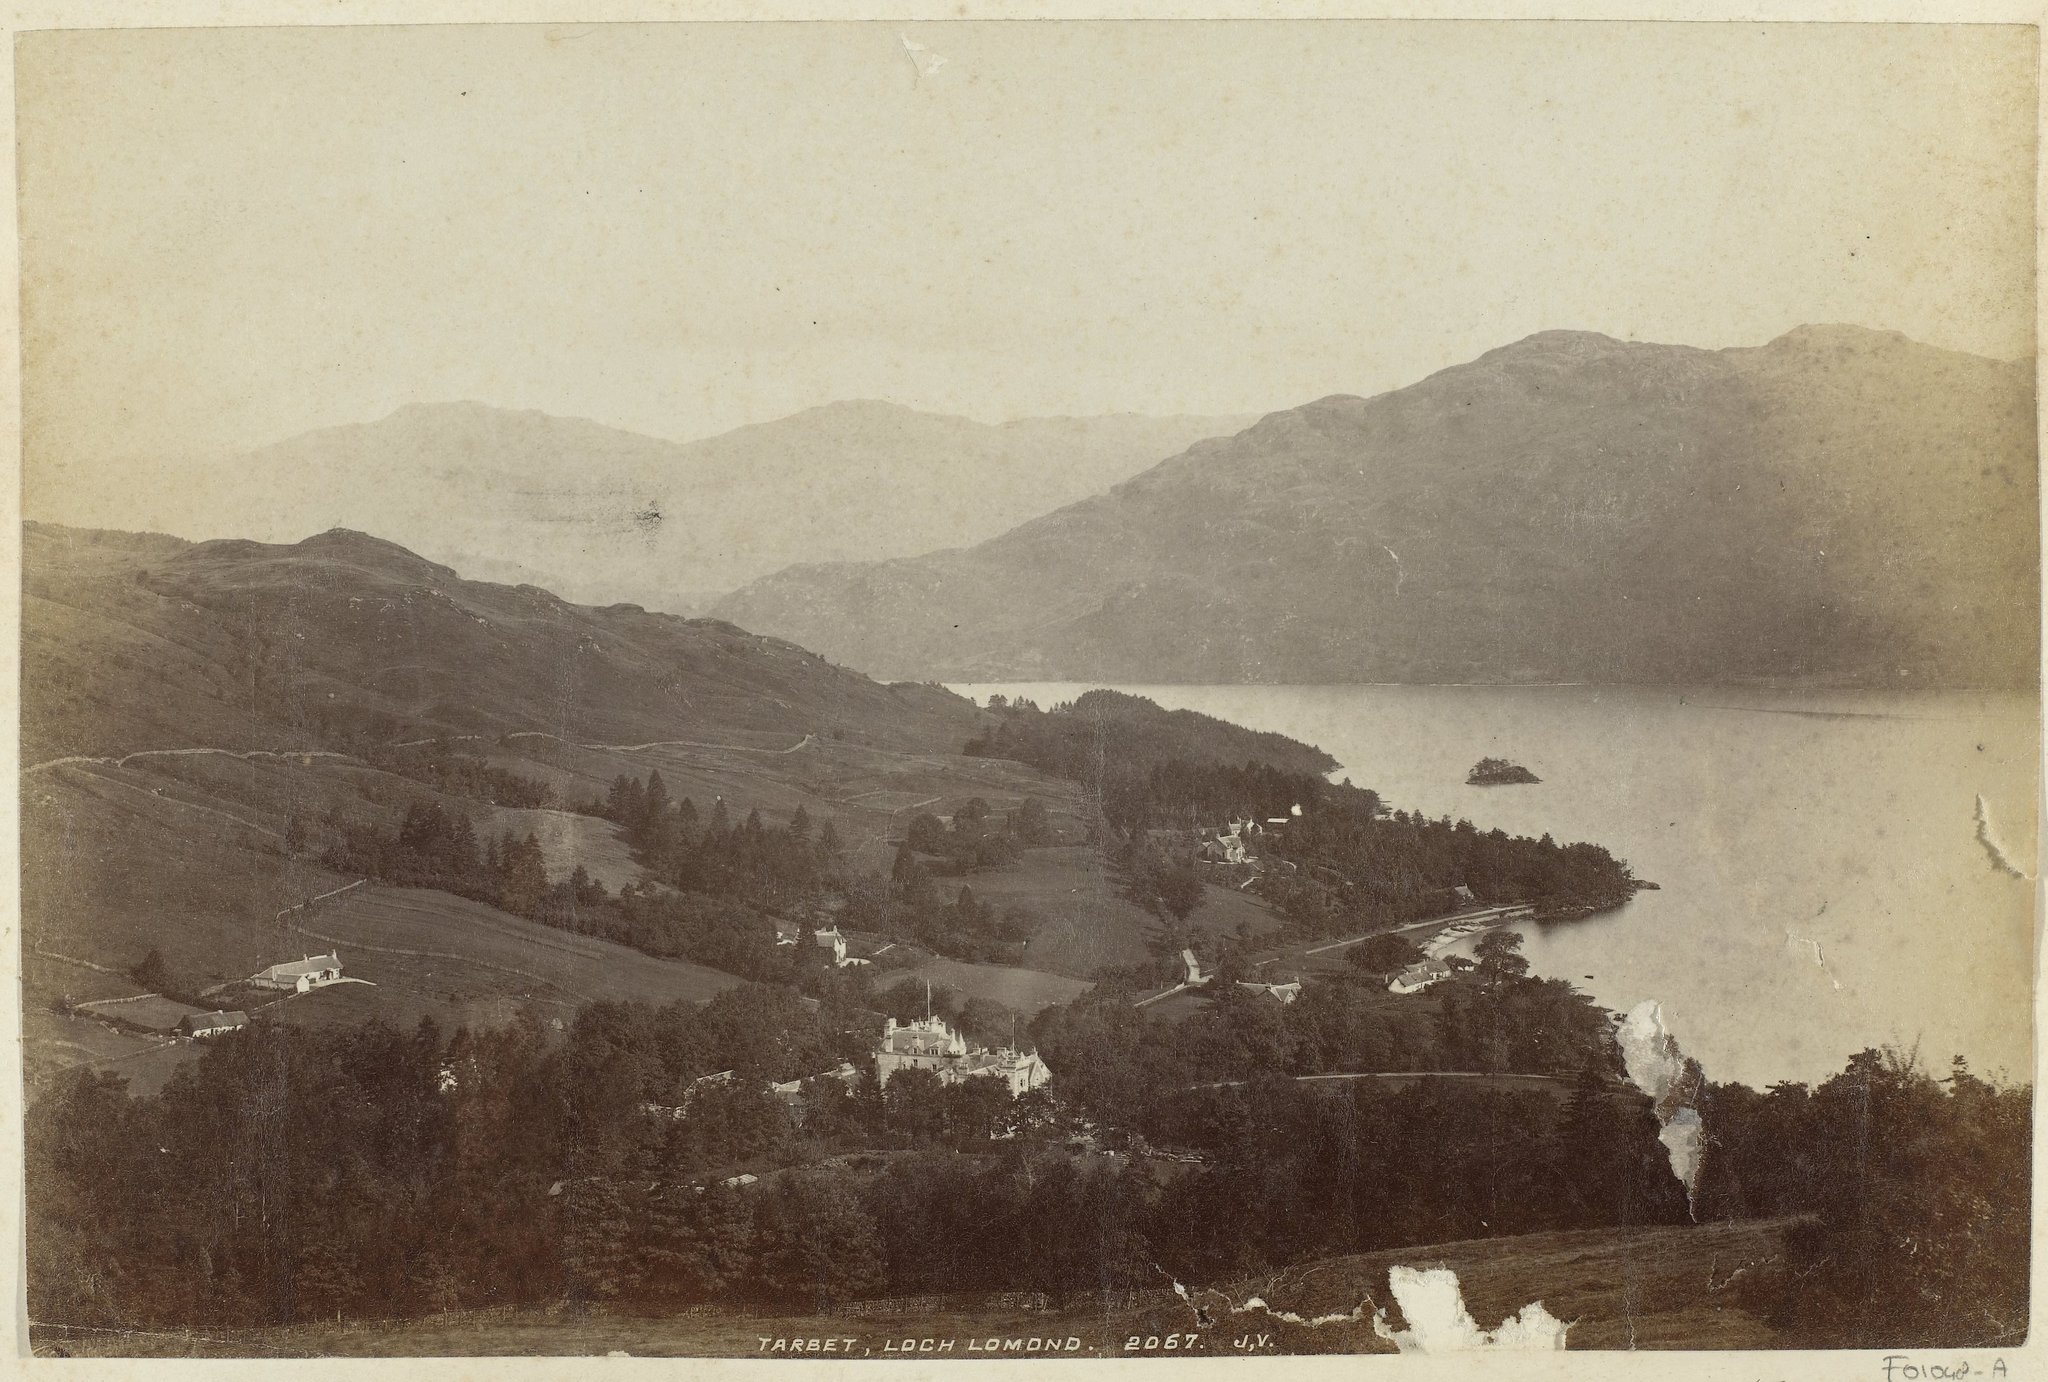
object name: photograph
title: Gezicht op Tarbet en Loch Lomond in Schotland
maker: james valentine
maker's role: fotograaf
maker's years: 1815-1880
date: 1870-1886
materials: paper, photographic support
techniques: albumen print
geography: tarbert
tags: prospect of village, silhouette of village, lake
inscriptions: date: ‘1886’, negative number: ‘2067’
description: Onderdeel van Reisalbum van H. Dunlop met foto's van bezienswaardigheden in Perzië, Schotland, Duitsland, Rusland, China en Canada.